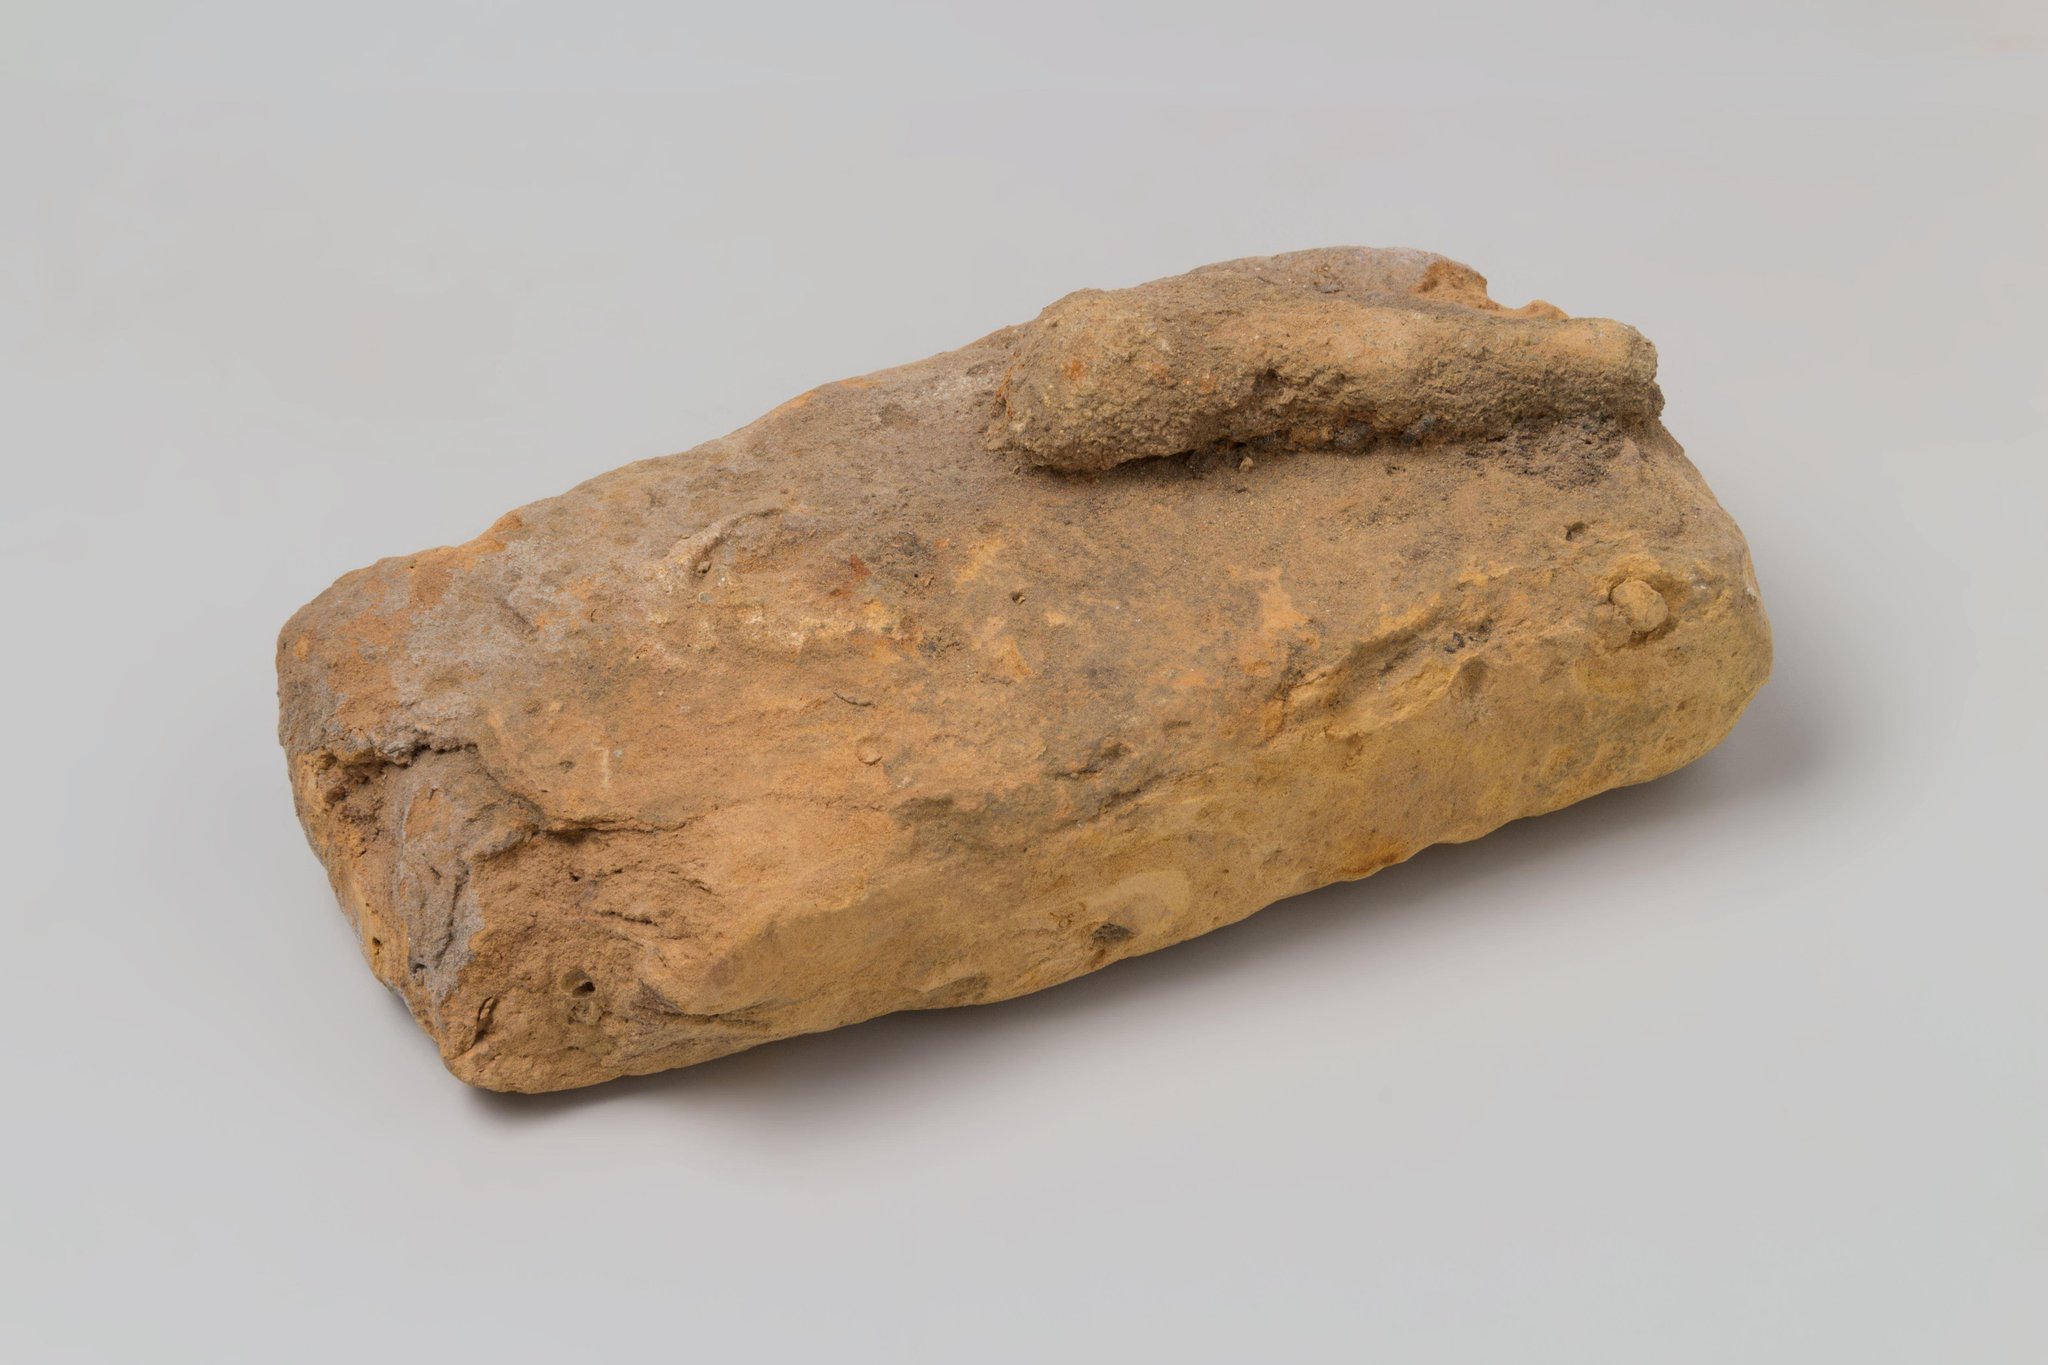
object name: brick clay product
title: Baksteen met stuk concretie uit het wrak van de Oost-Indiëvaarder 't Vliegend Hart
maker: Anonymous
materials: brick, stone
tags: 't vliegend hart (schip), verenigde oostindische compagnie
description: Rechthoekige, geelbruine baksteen met een stuk concretie. Brick.